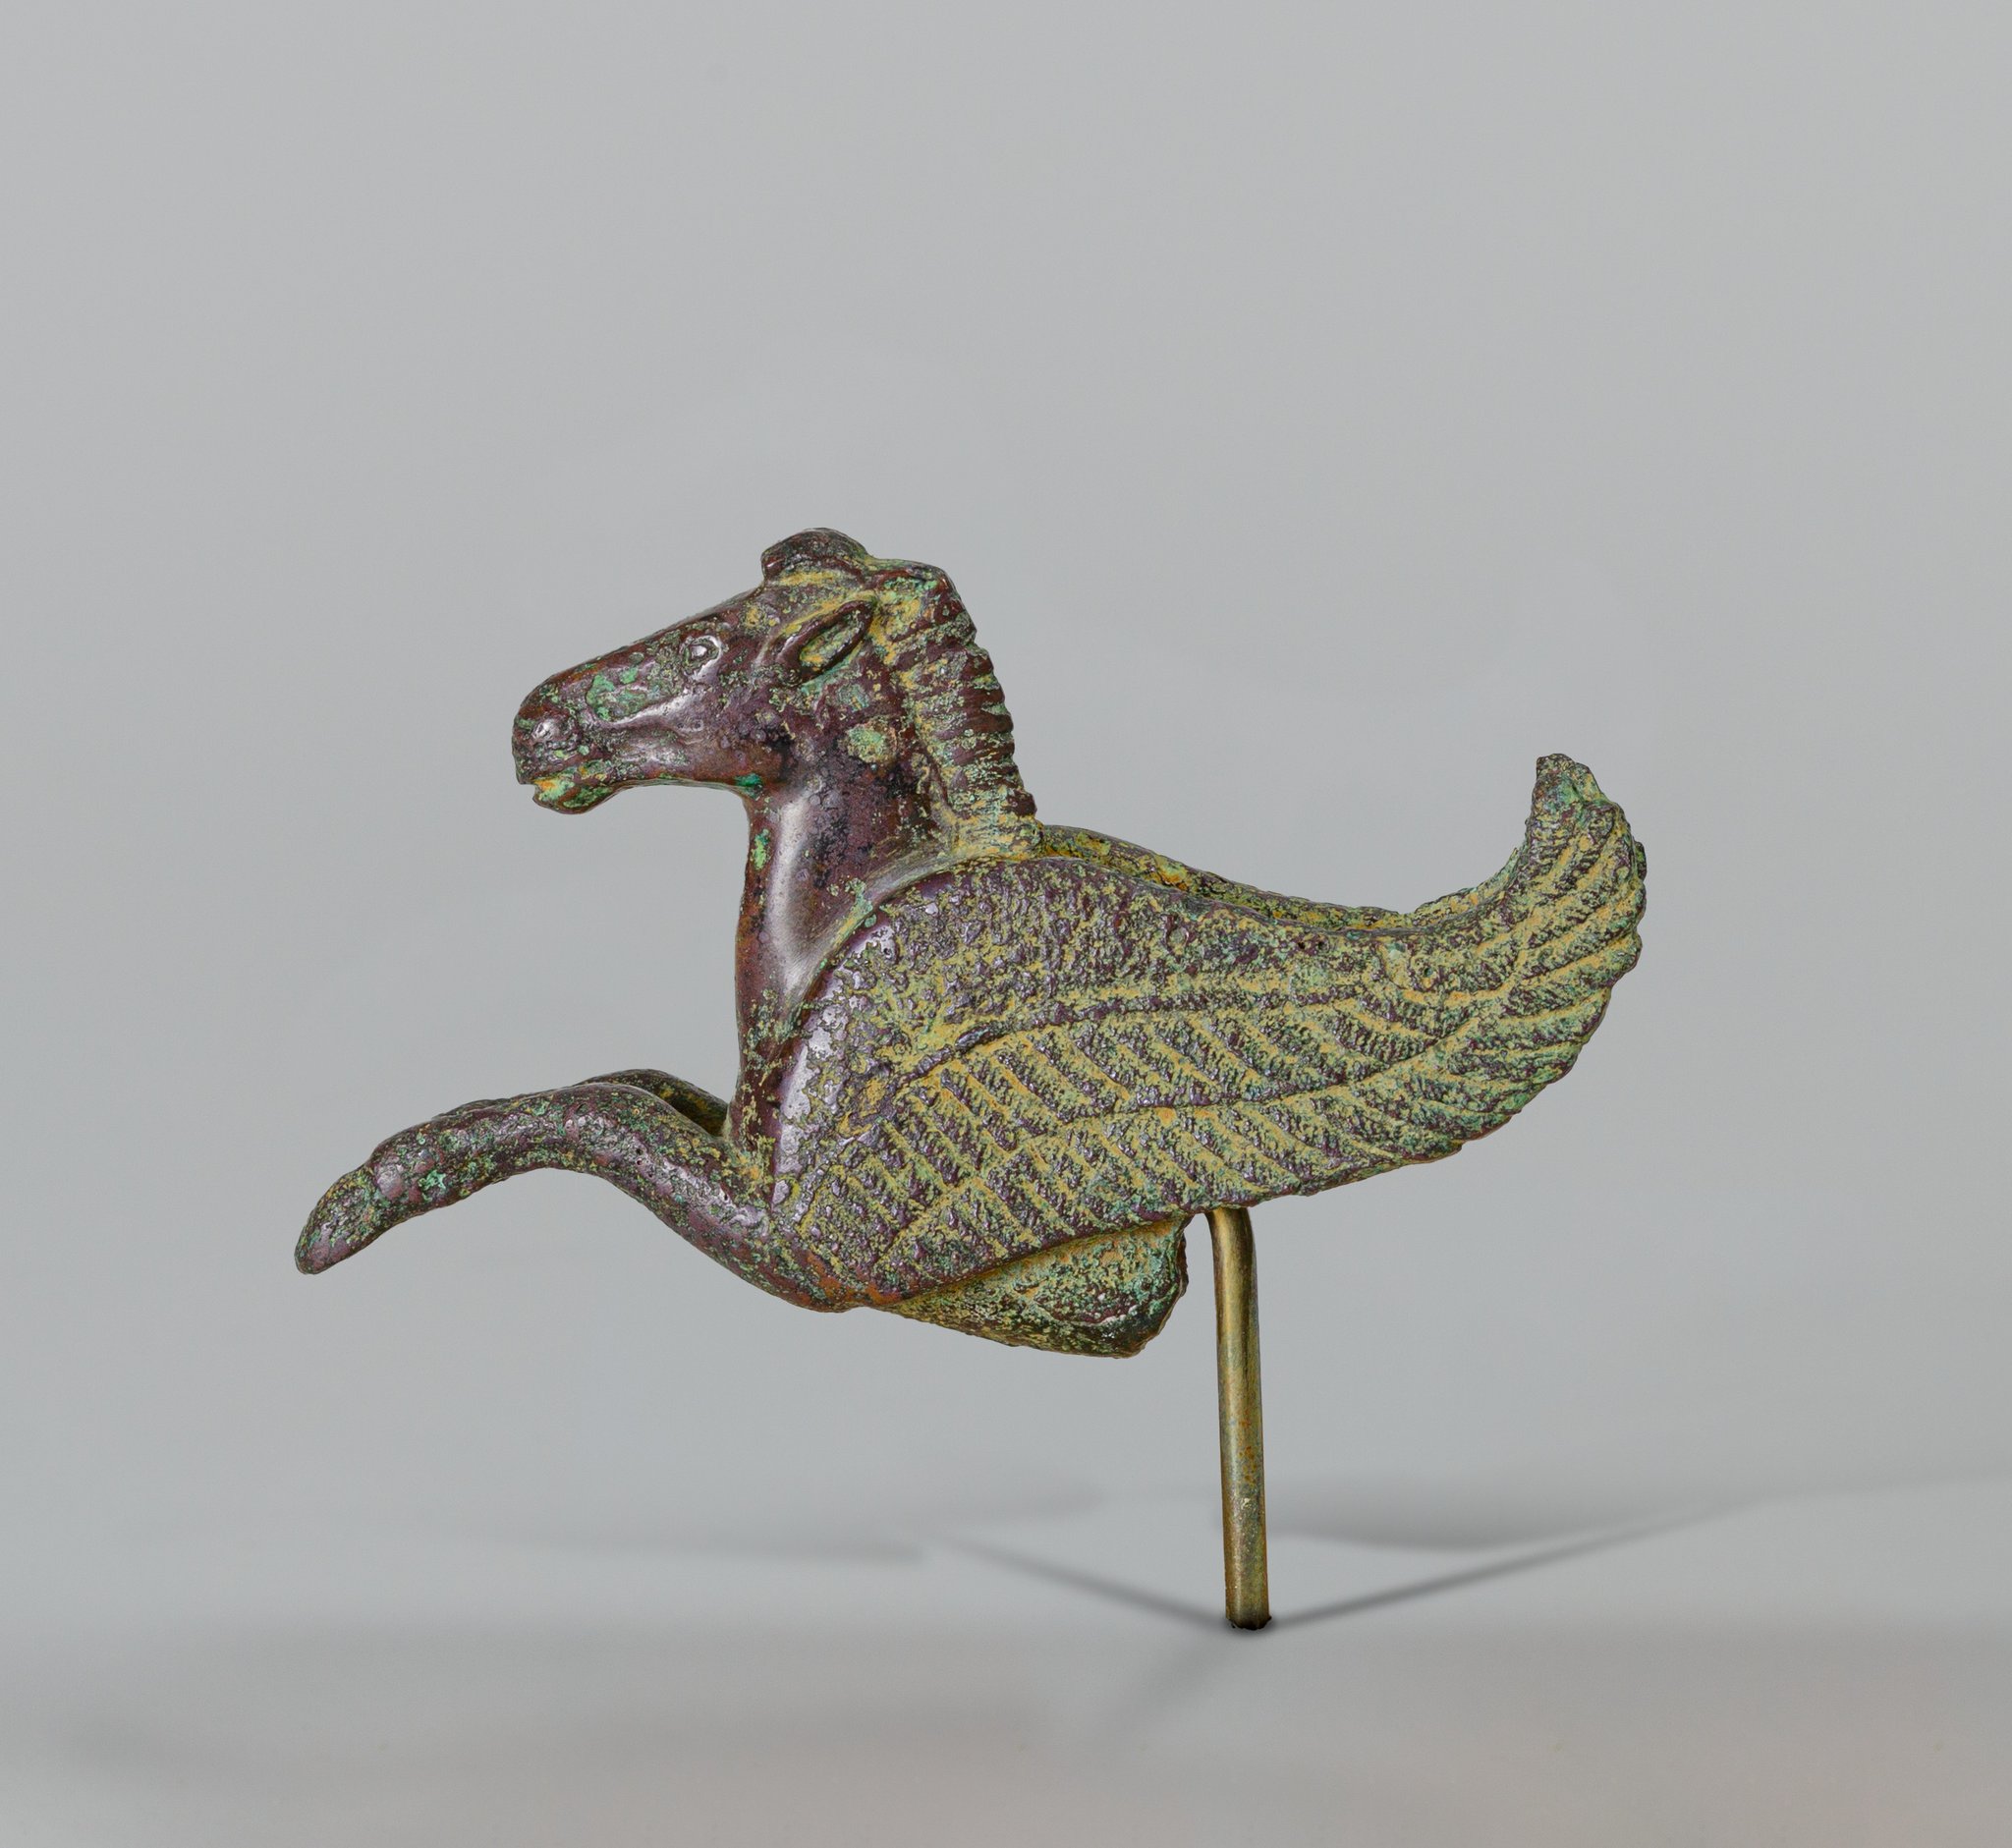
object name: forepart of a winged horse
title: Forepart of a bronze winged horse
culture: greek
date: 434-368 BCE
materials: bronze